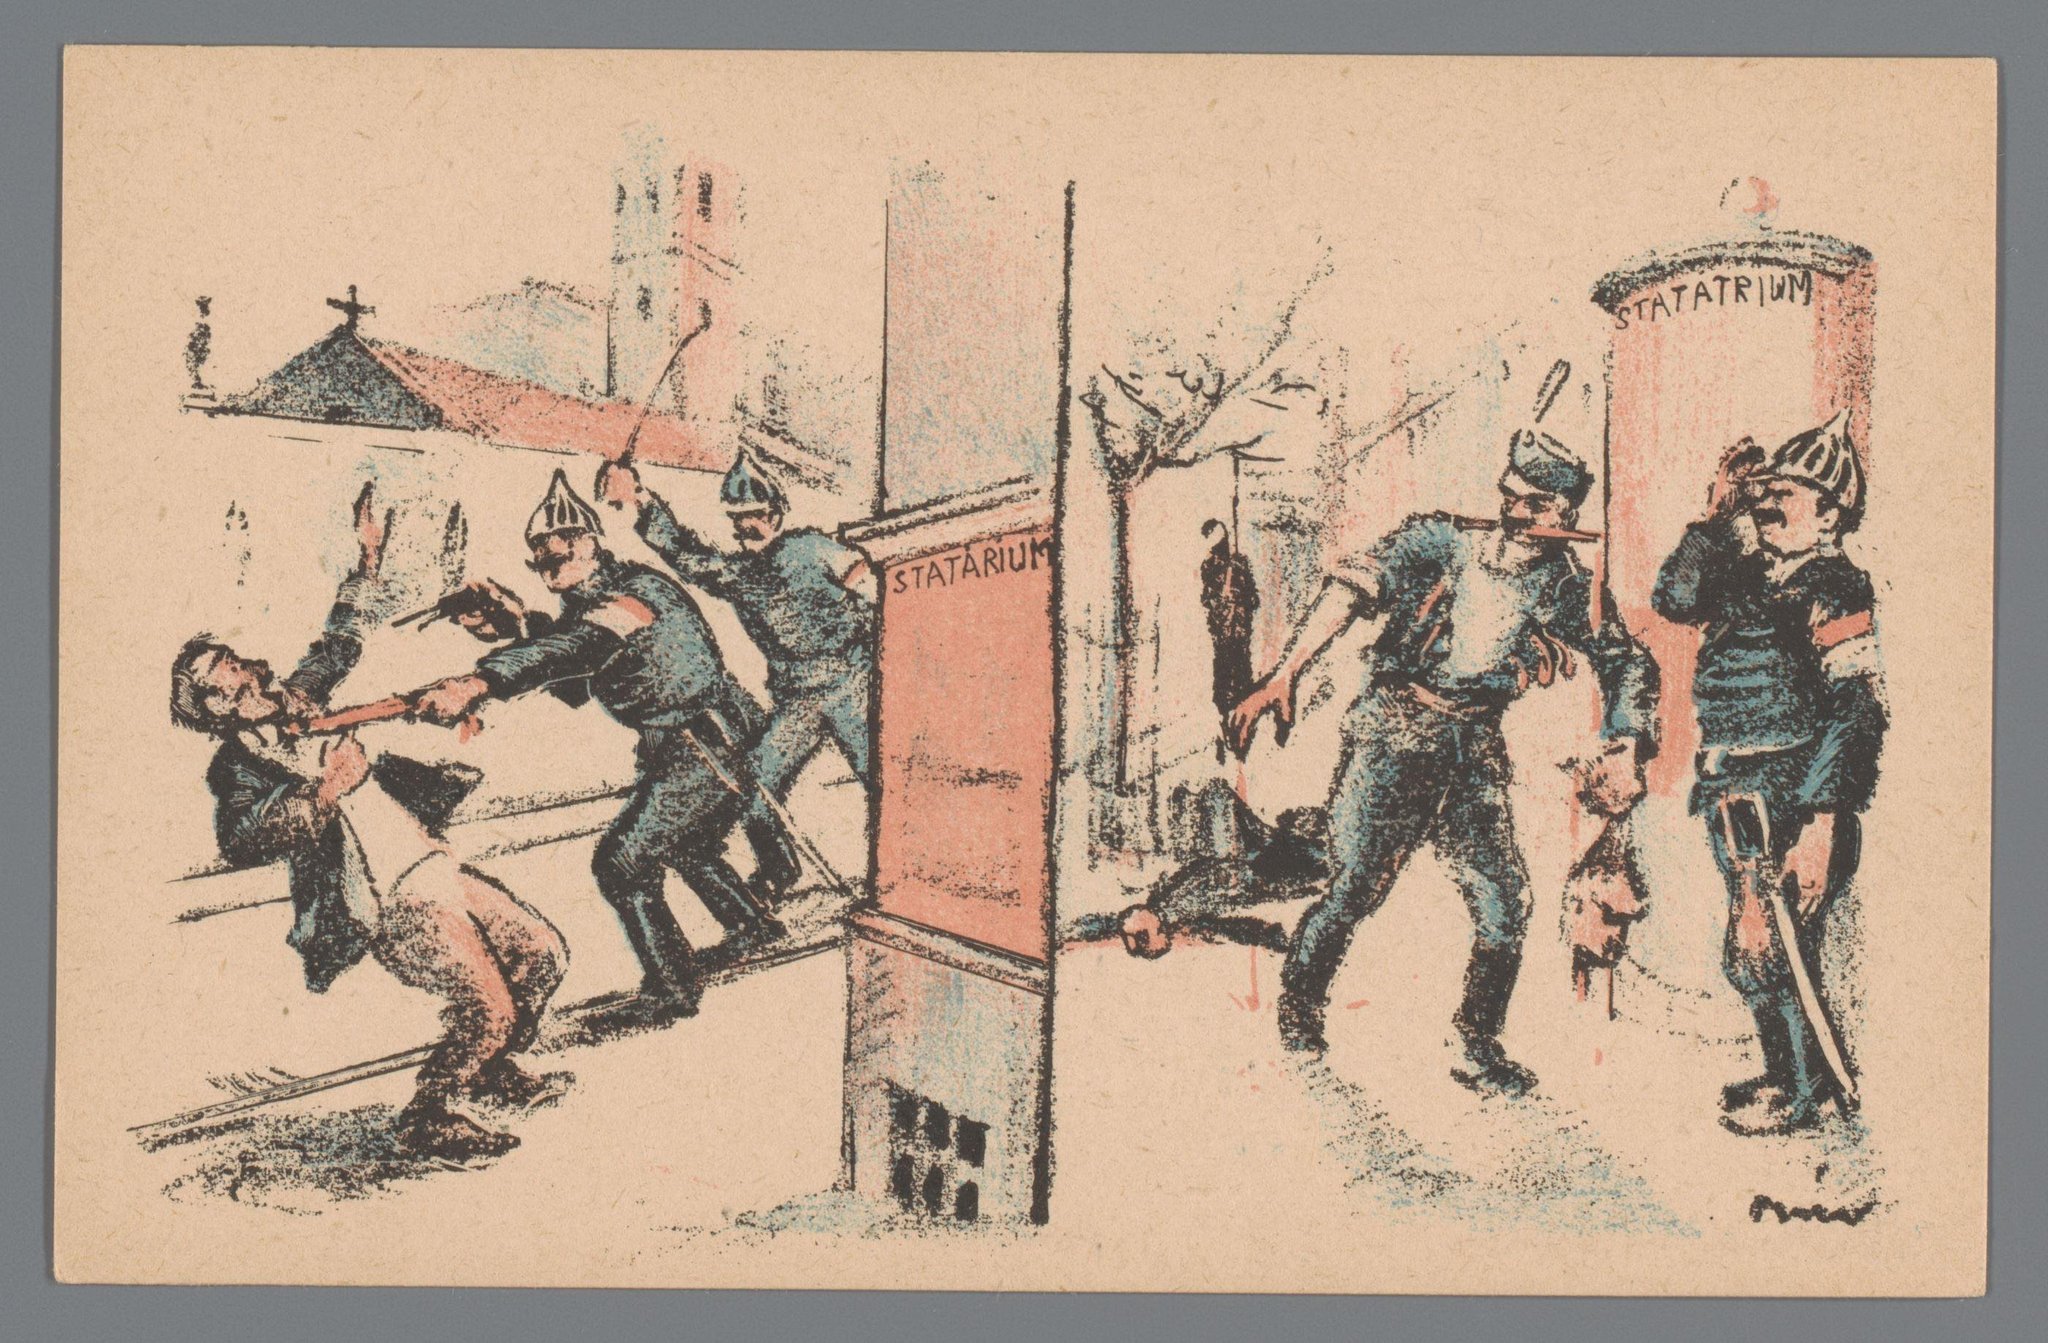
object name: ansichtkaart, prentbriefkaart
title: Horthy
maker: mihály biró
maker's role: draughtsman, painter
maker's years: 1886-1948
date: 1920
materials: paper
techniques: letterpress printing, lithograph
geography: vienna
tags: racial discrimination, segregation, reign of terror, violent death, being killed; being mishandled and maltreated; seeking death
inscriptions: collector's mark: Lugt 2228, : ‘Verlag der Arbeiter-Buchhandlung, Wien, VIII. Alserstrasse 69.’, : ‘Nachdruk verboten.’, : ‘Original Lithographie von Michael Biró.’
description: Voorstelling van de barre omstandigheden in Hongarije ten tijde van witte terreur onder het schrikbewind van Miklós Horthy. Titel op object in het Hongaars, Frans, Duits, Engels en Russisch en tekst in het Duits op verso.